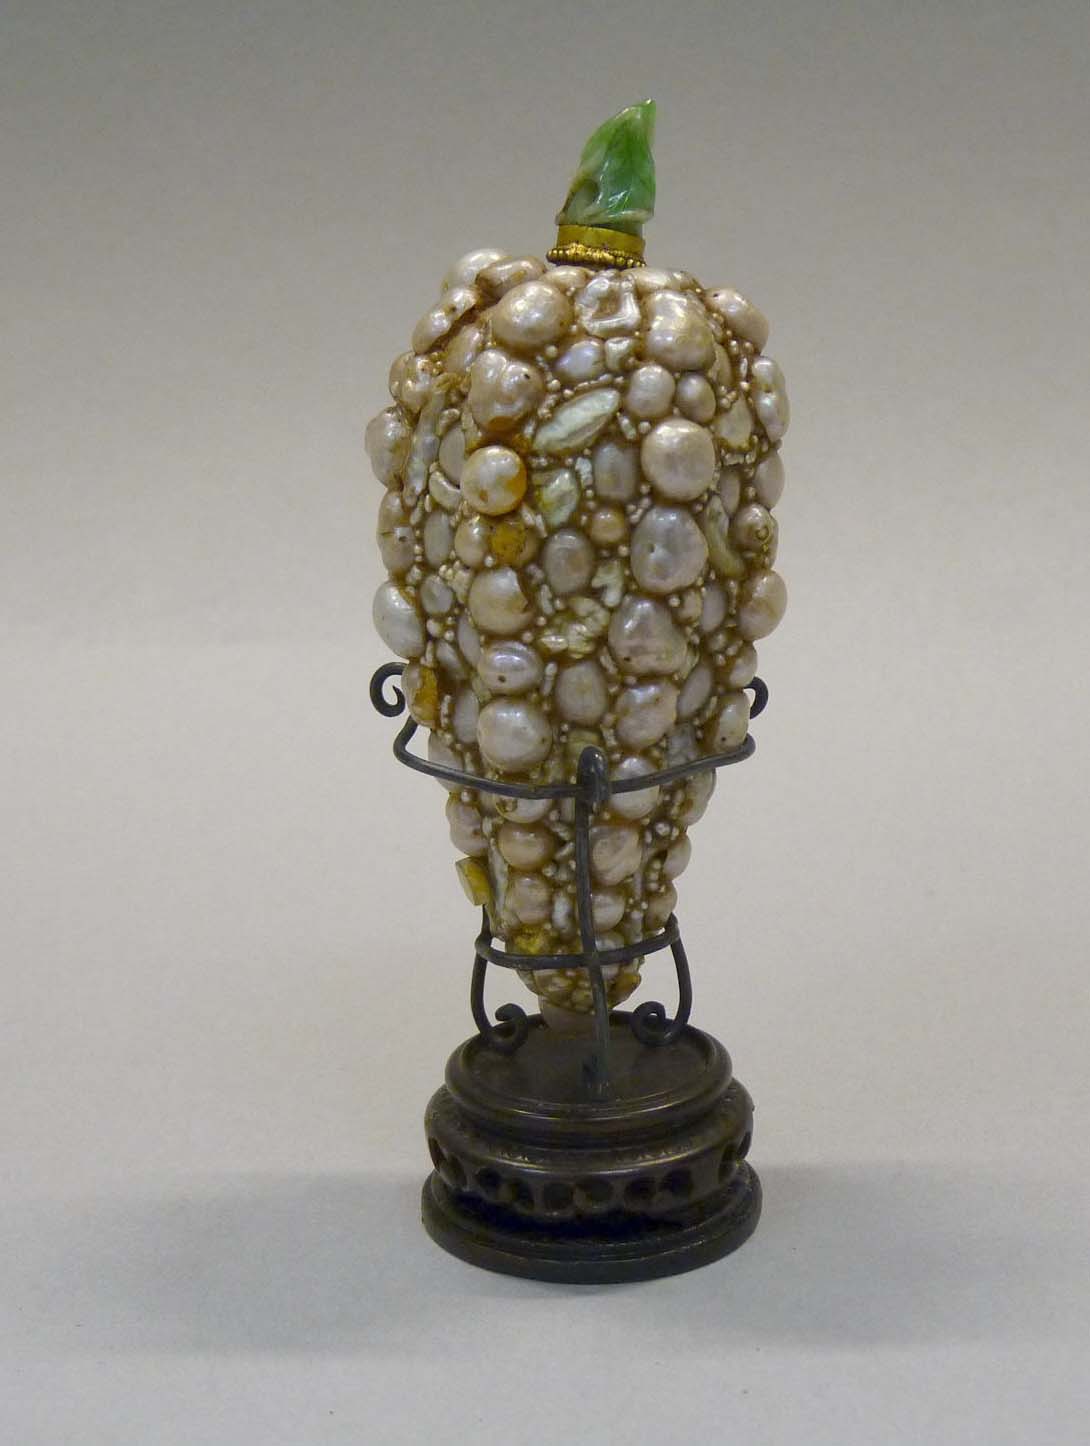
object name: snuff bottle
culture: chinese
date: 1801-1900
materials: jade, pearl